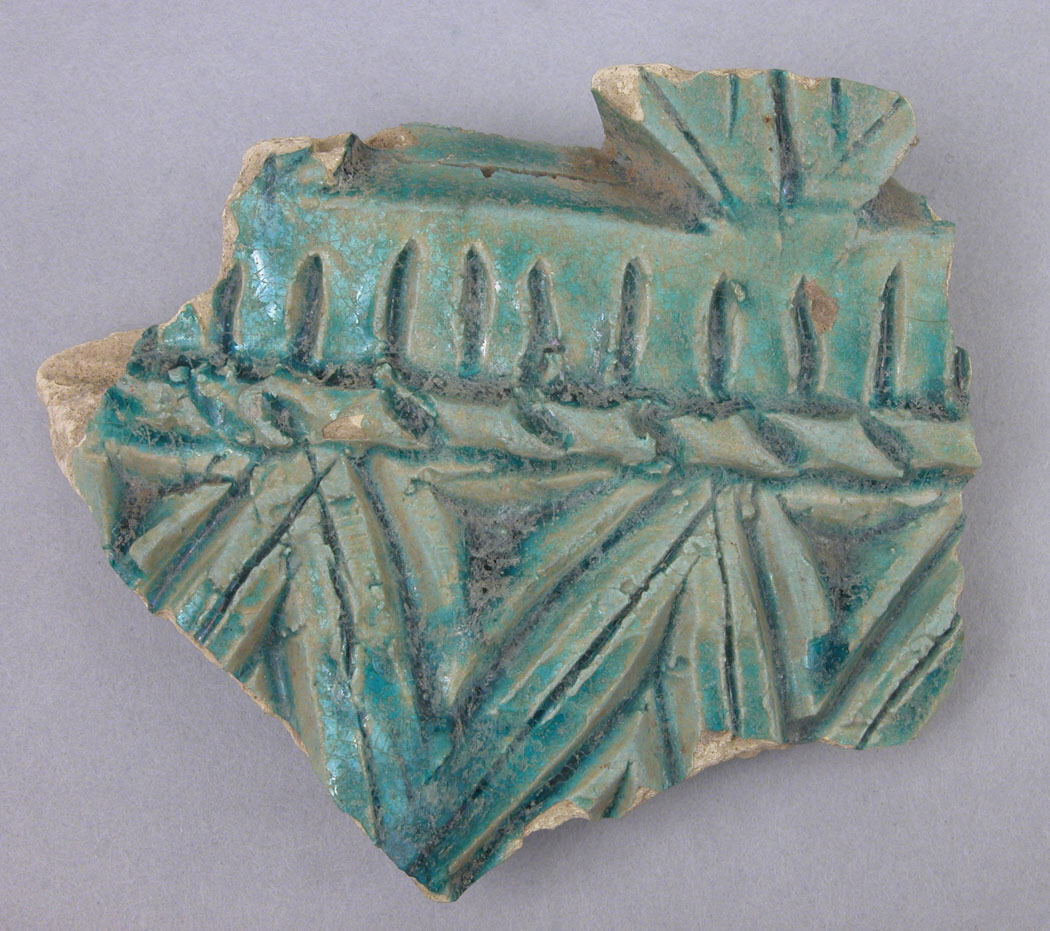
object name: fragment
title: Fragment with Excised Motif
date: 601-900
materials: earthenware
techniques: glazing, incising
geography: iraq